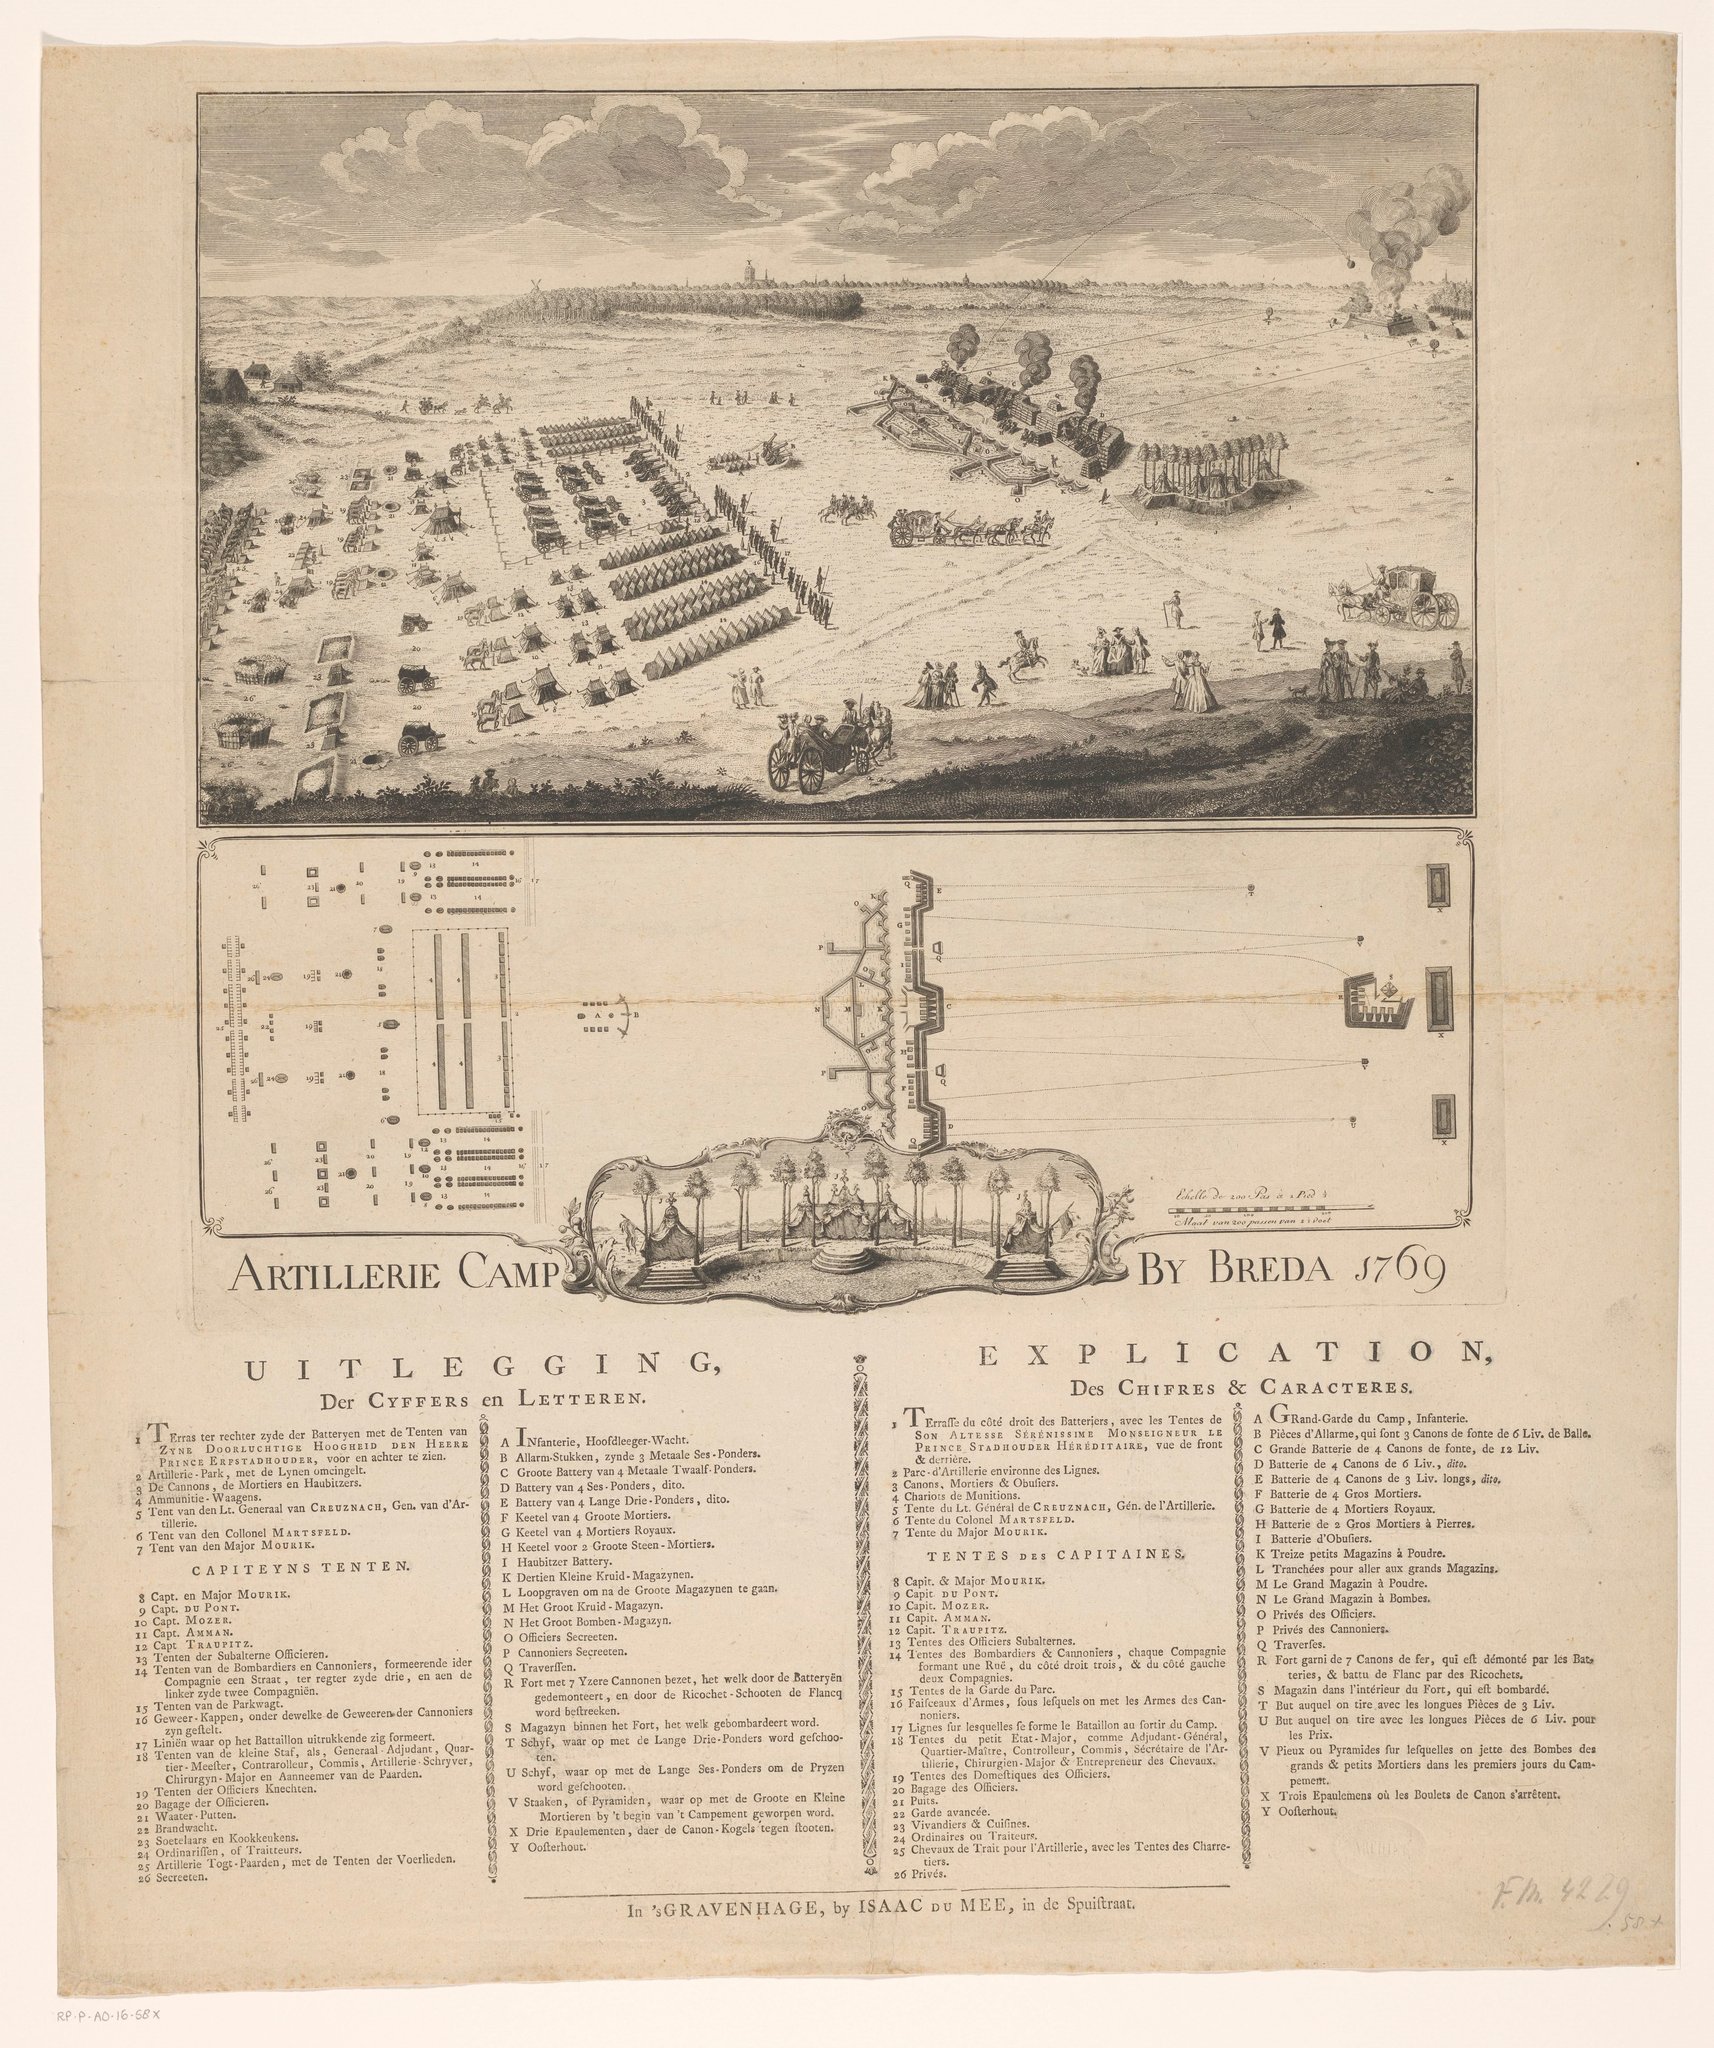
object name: print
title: Artillerie camp by Breda 1769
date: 1769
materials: paper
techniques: engraving, etching, letterpress printing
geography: the hague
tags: the hague, william v (prince of orange), (military) camp with tents, manoeuvre ~ military training (+ artillery)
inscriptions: check stamp: ‘Archief Ministerie van Oorlog Afdeeling Genie’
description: Gezicht op het artilleriekamp van het Staatse Leger buiten Breda, waar het leger in juni 1769 oefeningen hield. Bovenaan een voorstelling van de schietoefeningen, daaronder een plattegrond van het oefengebied met het schietterrein en het legerkamp, met rechtsonder een schaalstok: Echelle de 200 Pas a 2 Pied 1/2 / Maat van 200 passen van 2 1/2 Voet. In het midden een cartouche met de tenten van de prins. Op het blad onder de plaat legenda's in het Nederlands en Frans.